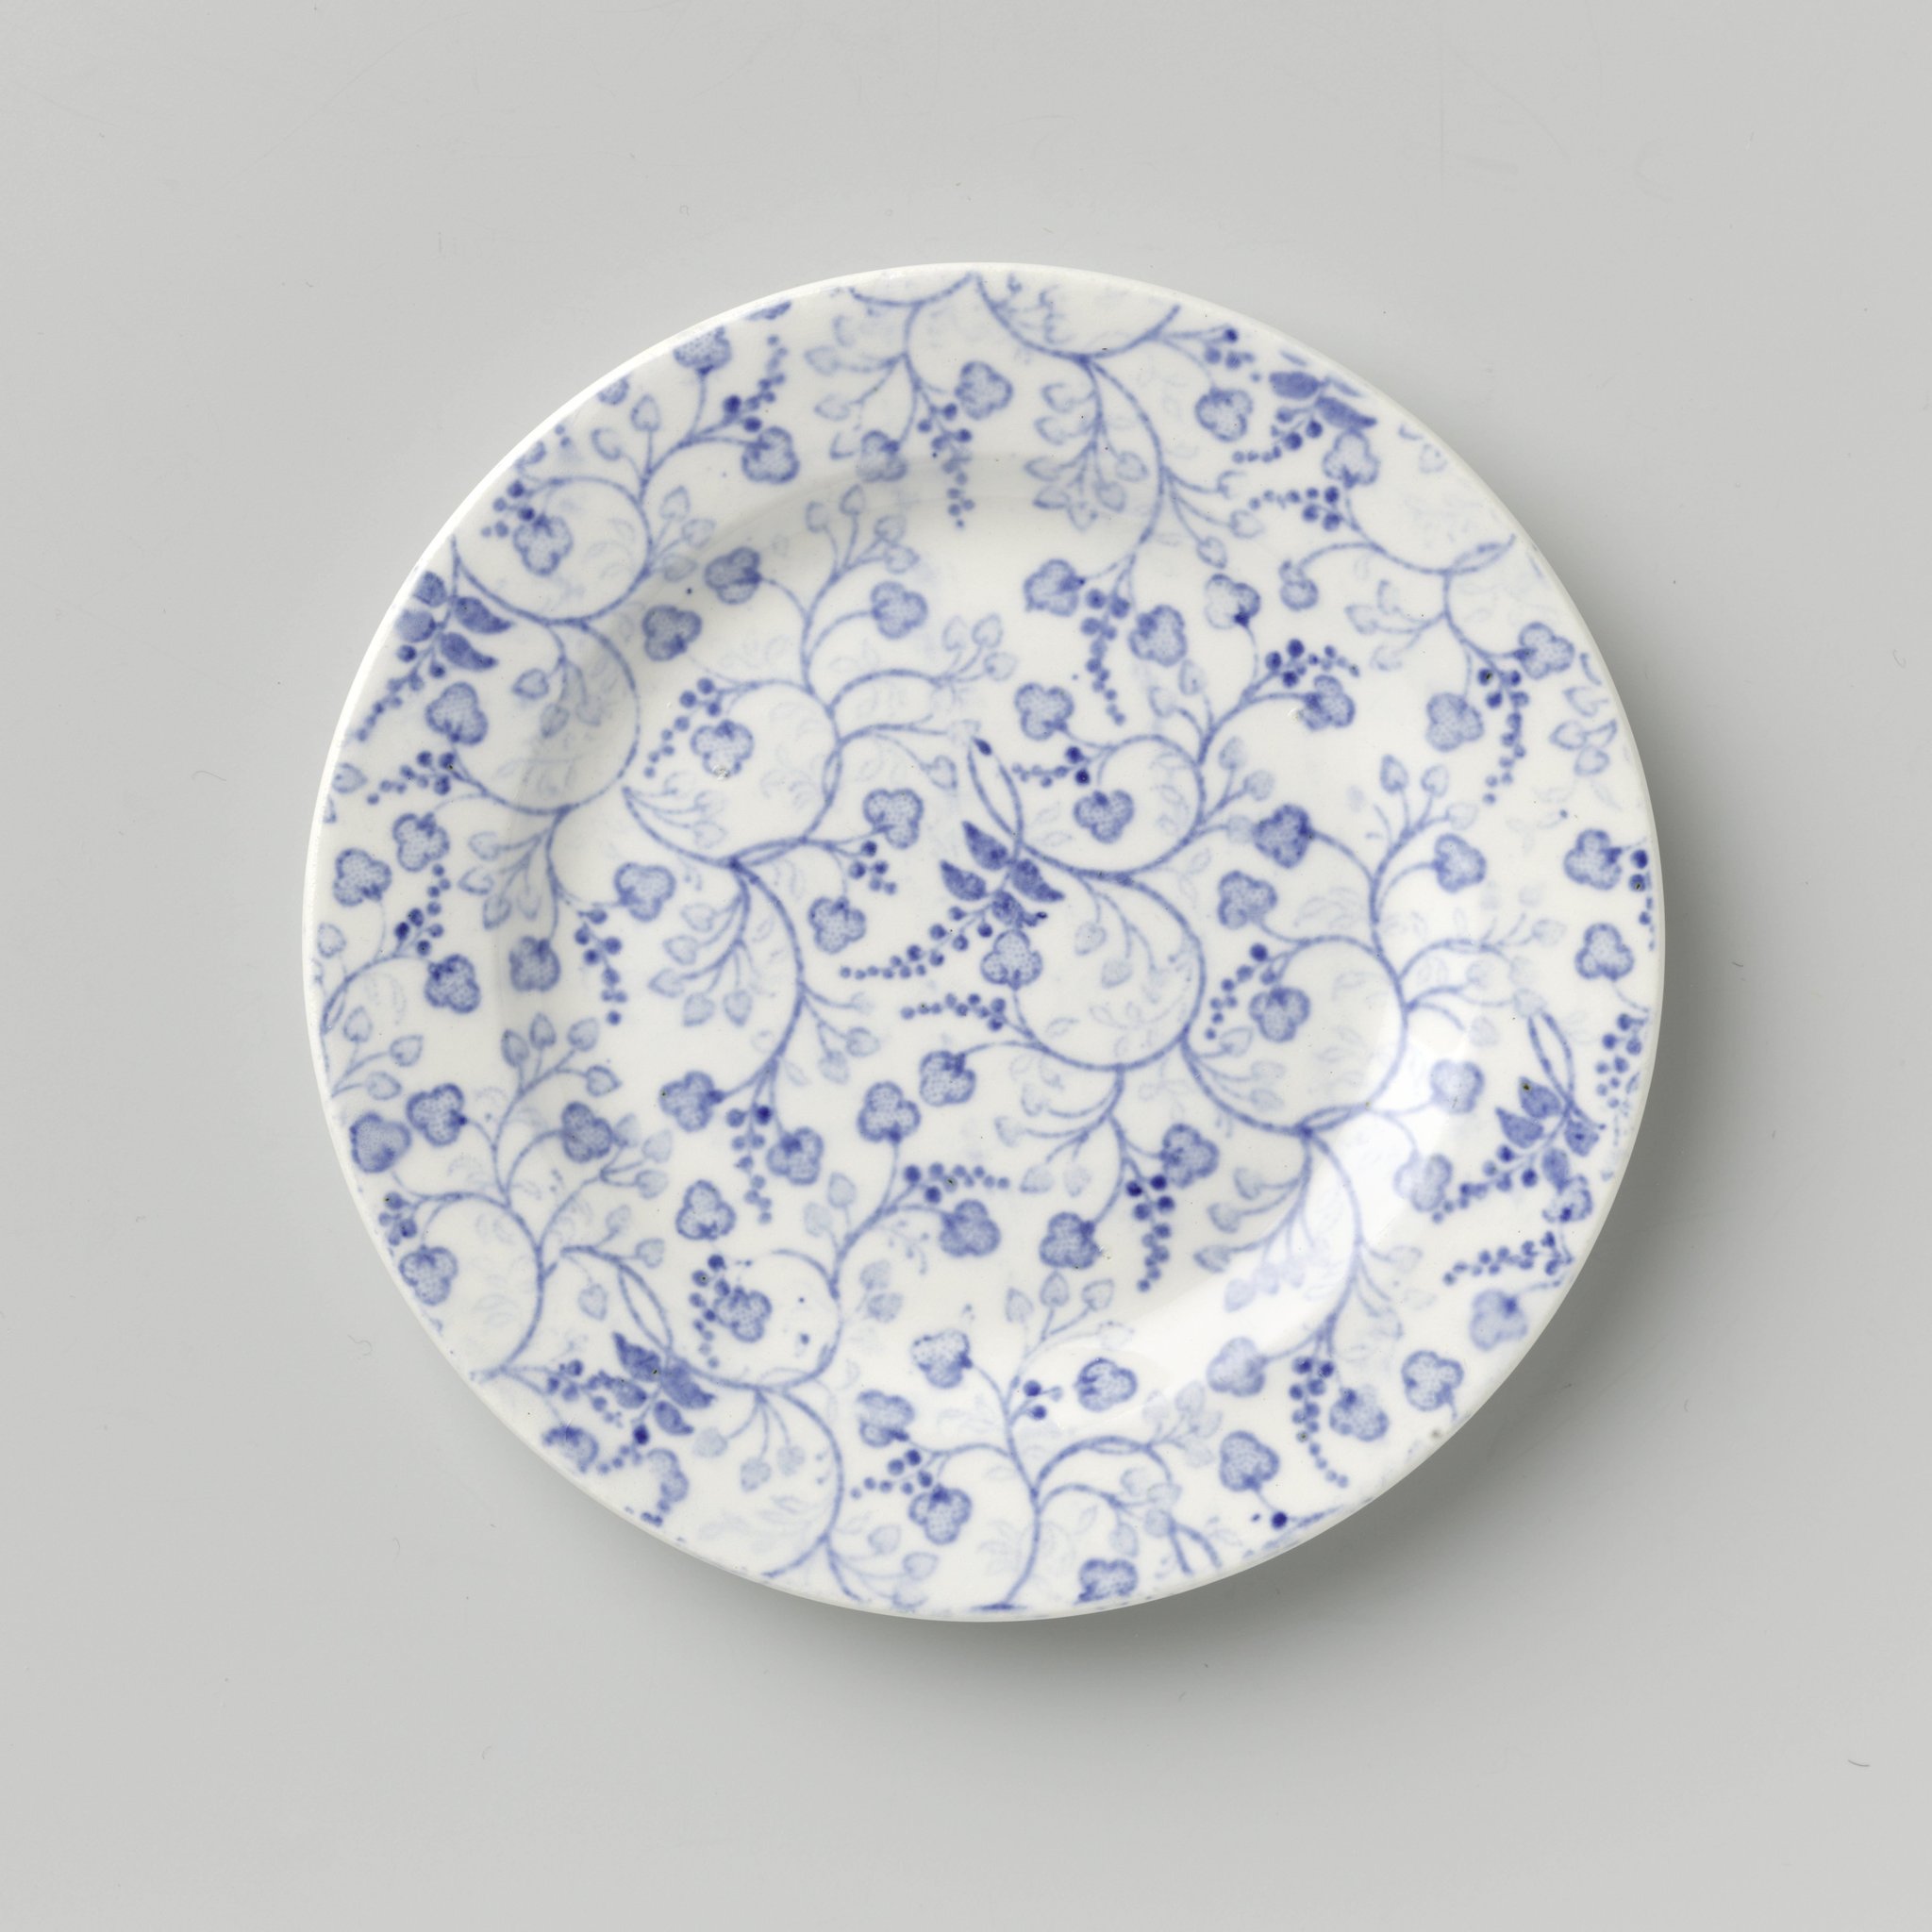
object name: plate dish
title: Bord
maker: petrus regout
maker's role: plateelbakker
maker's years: 1801-1879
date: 1867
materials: creamware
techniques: transfer decoration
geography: maastricht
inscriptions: mark: ‘PARSEME No 3’, check stamp: ‘PR // 29’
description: Bord van aardewerk, met blauw doorlopend bloemendecor, behorend tot een kinderservies.